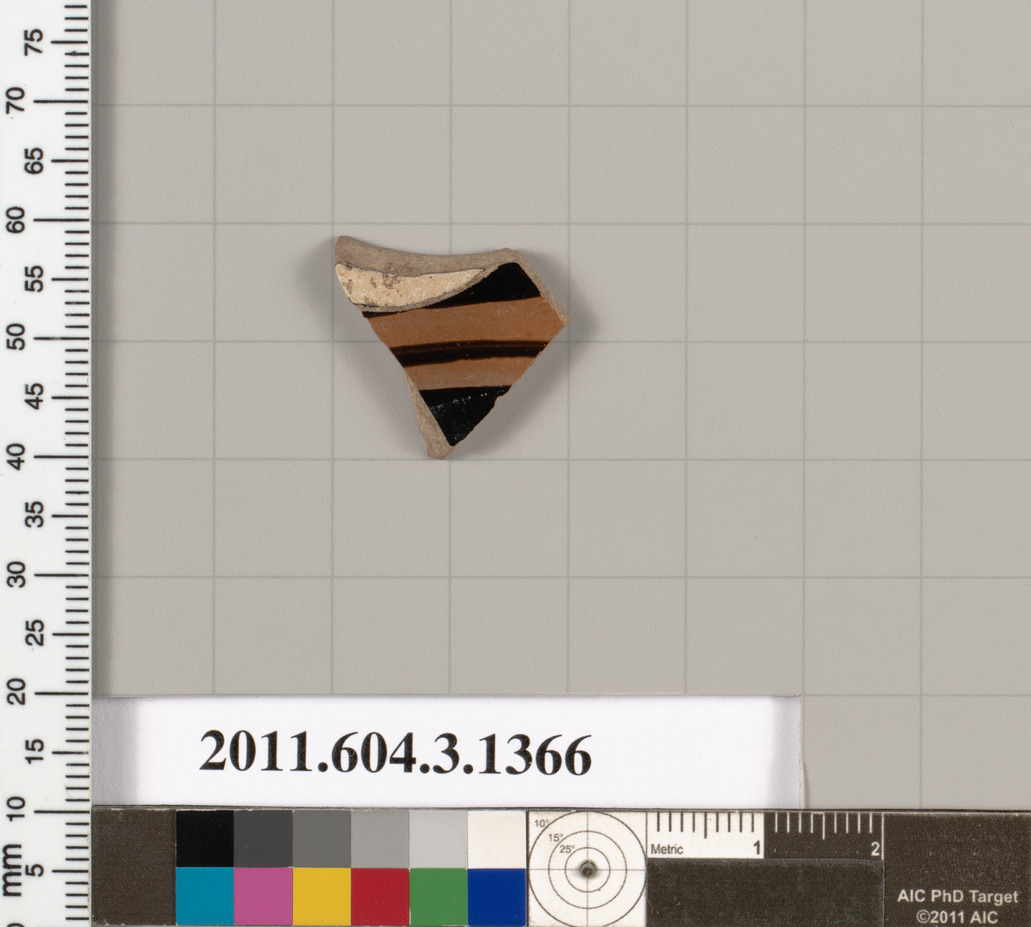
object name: skyphos fragment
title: Terracotta fragment of a skyphos (deep drinking cup)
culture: greek, attic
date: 500-468 BCE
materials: terracotta